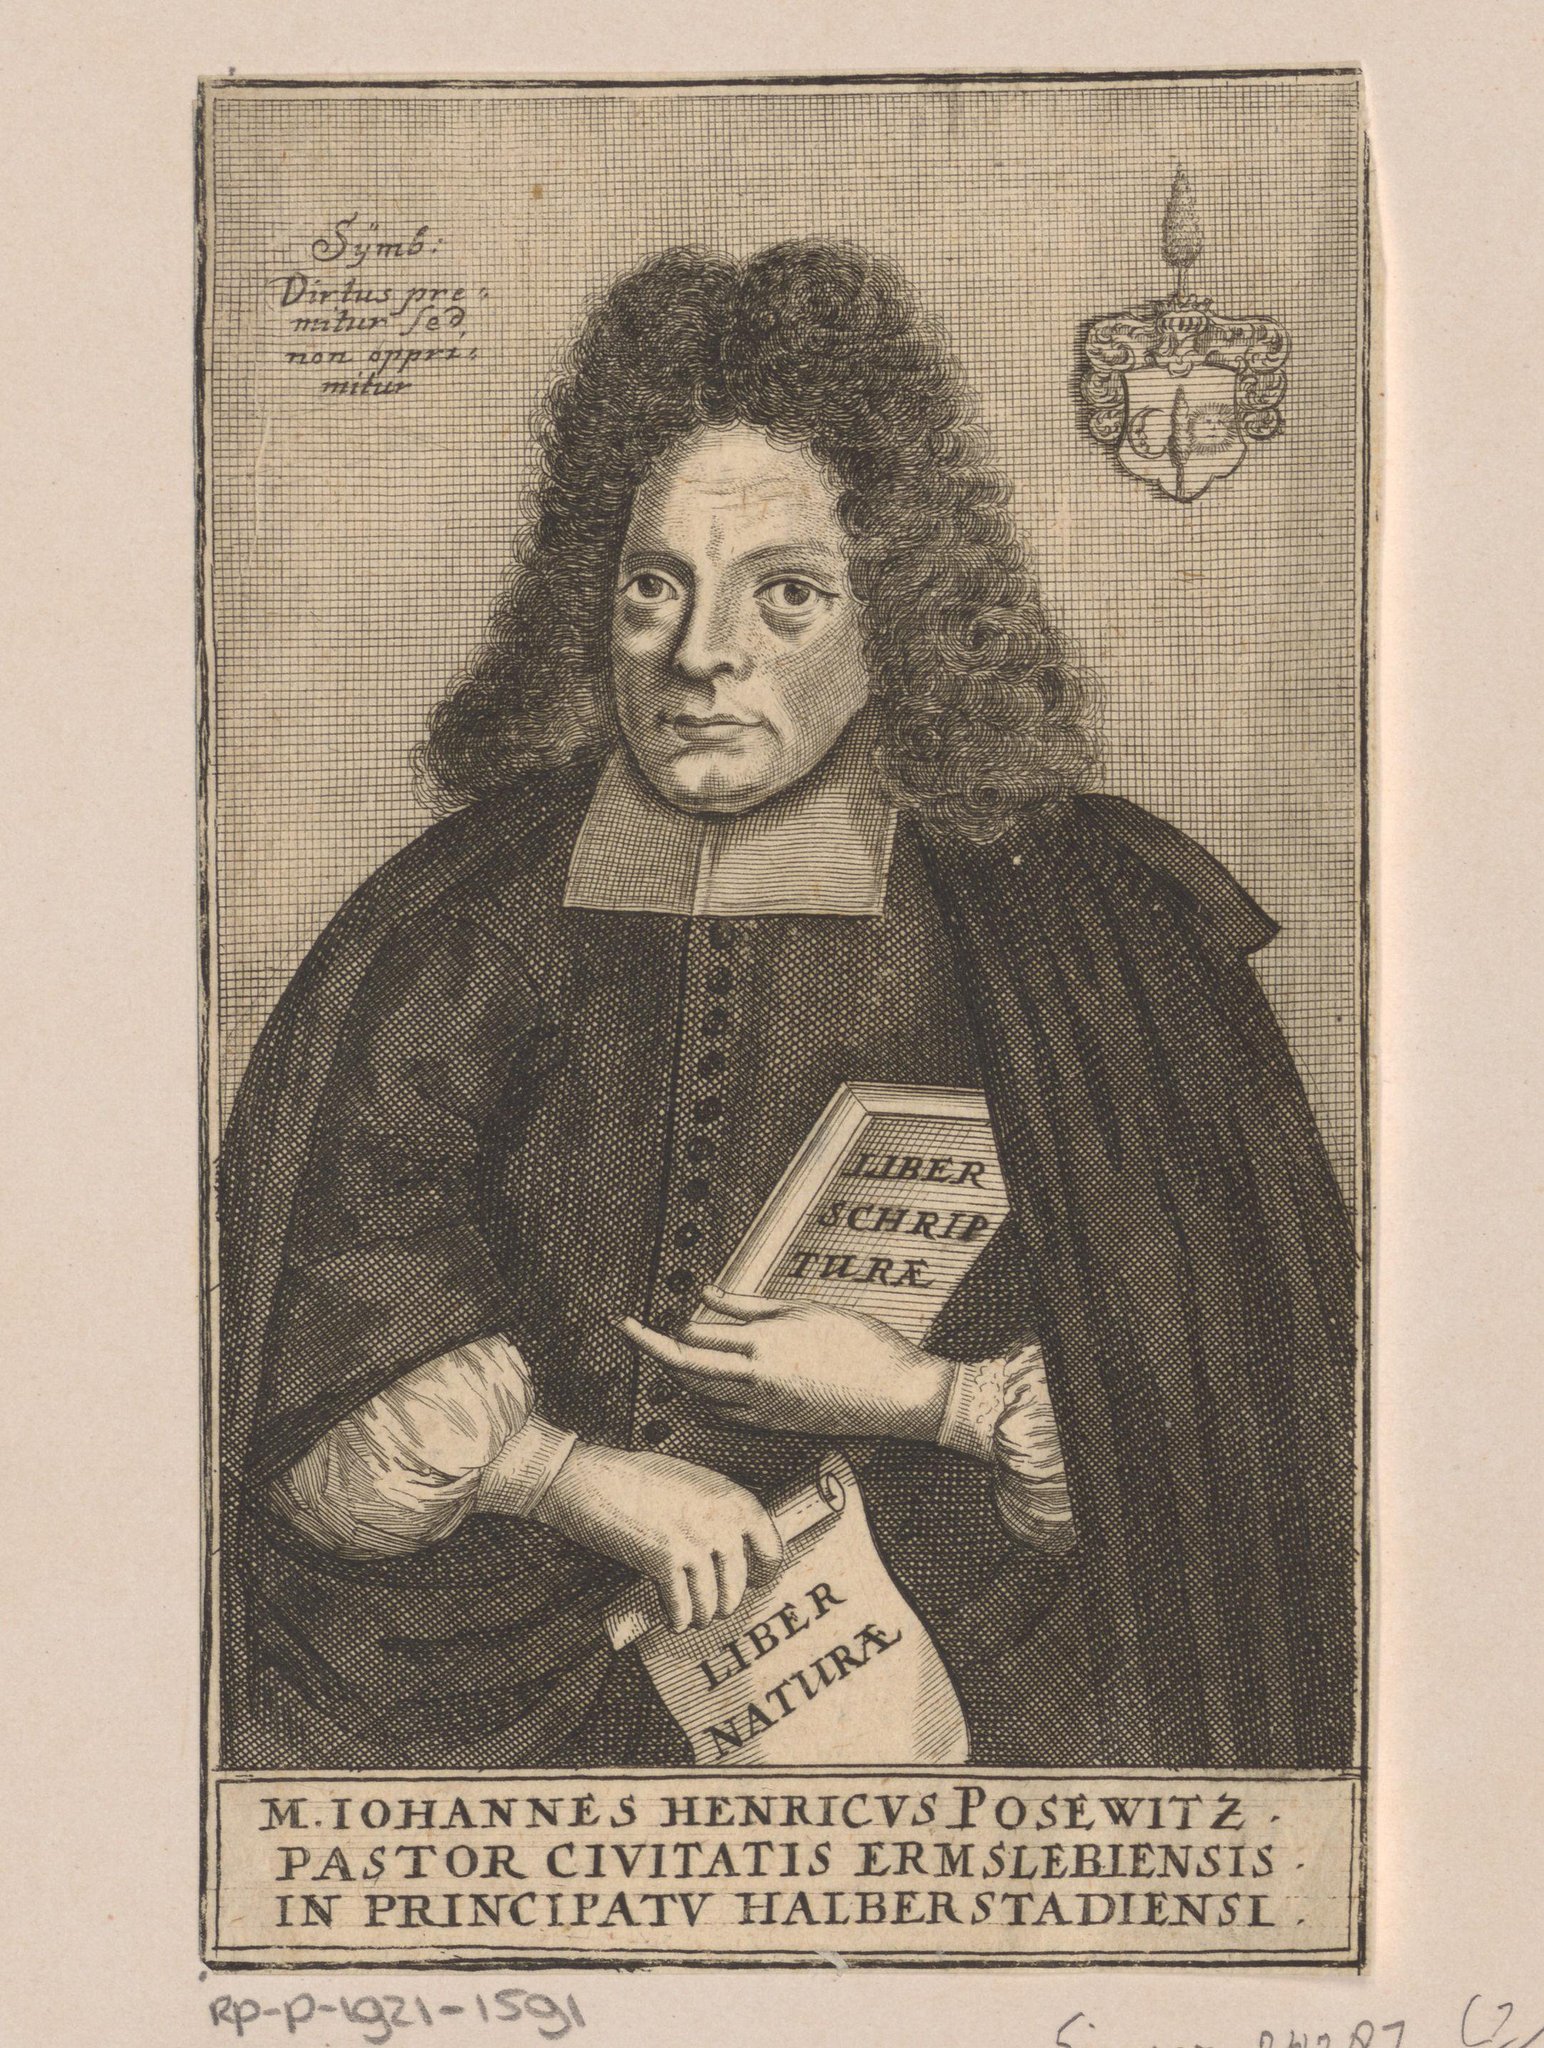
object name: print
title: Portret van Johann Heinrich Posewitz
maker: Anonymous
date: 1661-1699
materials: paper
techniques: engraving, etching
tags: historical persons, physician, doctor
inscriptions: collector's mark: Lugt 2233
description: Met drieregelig onderschrift in het Latijn.